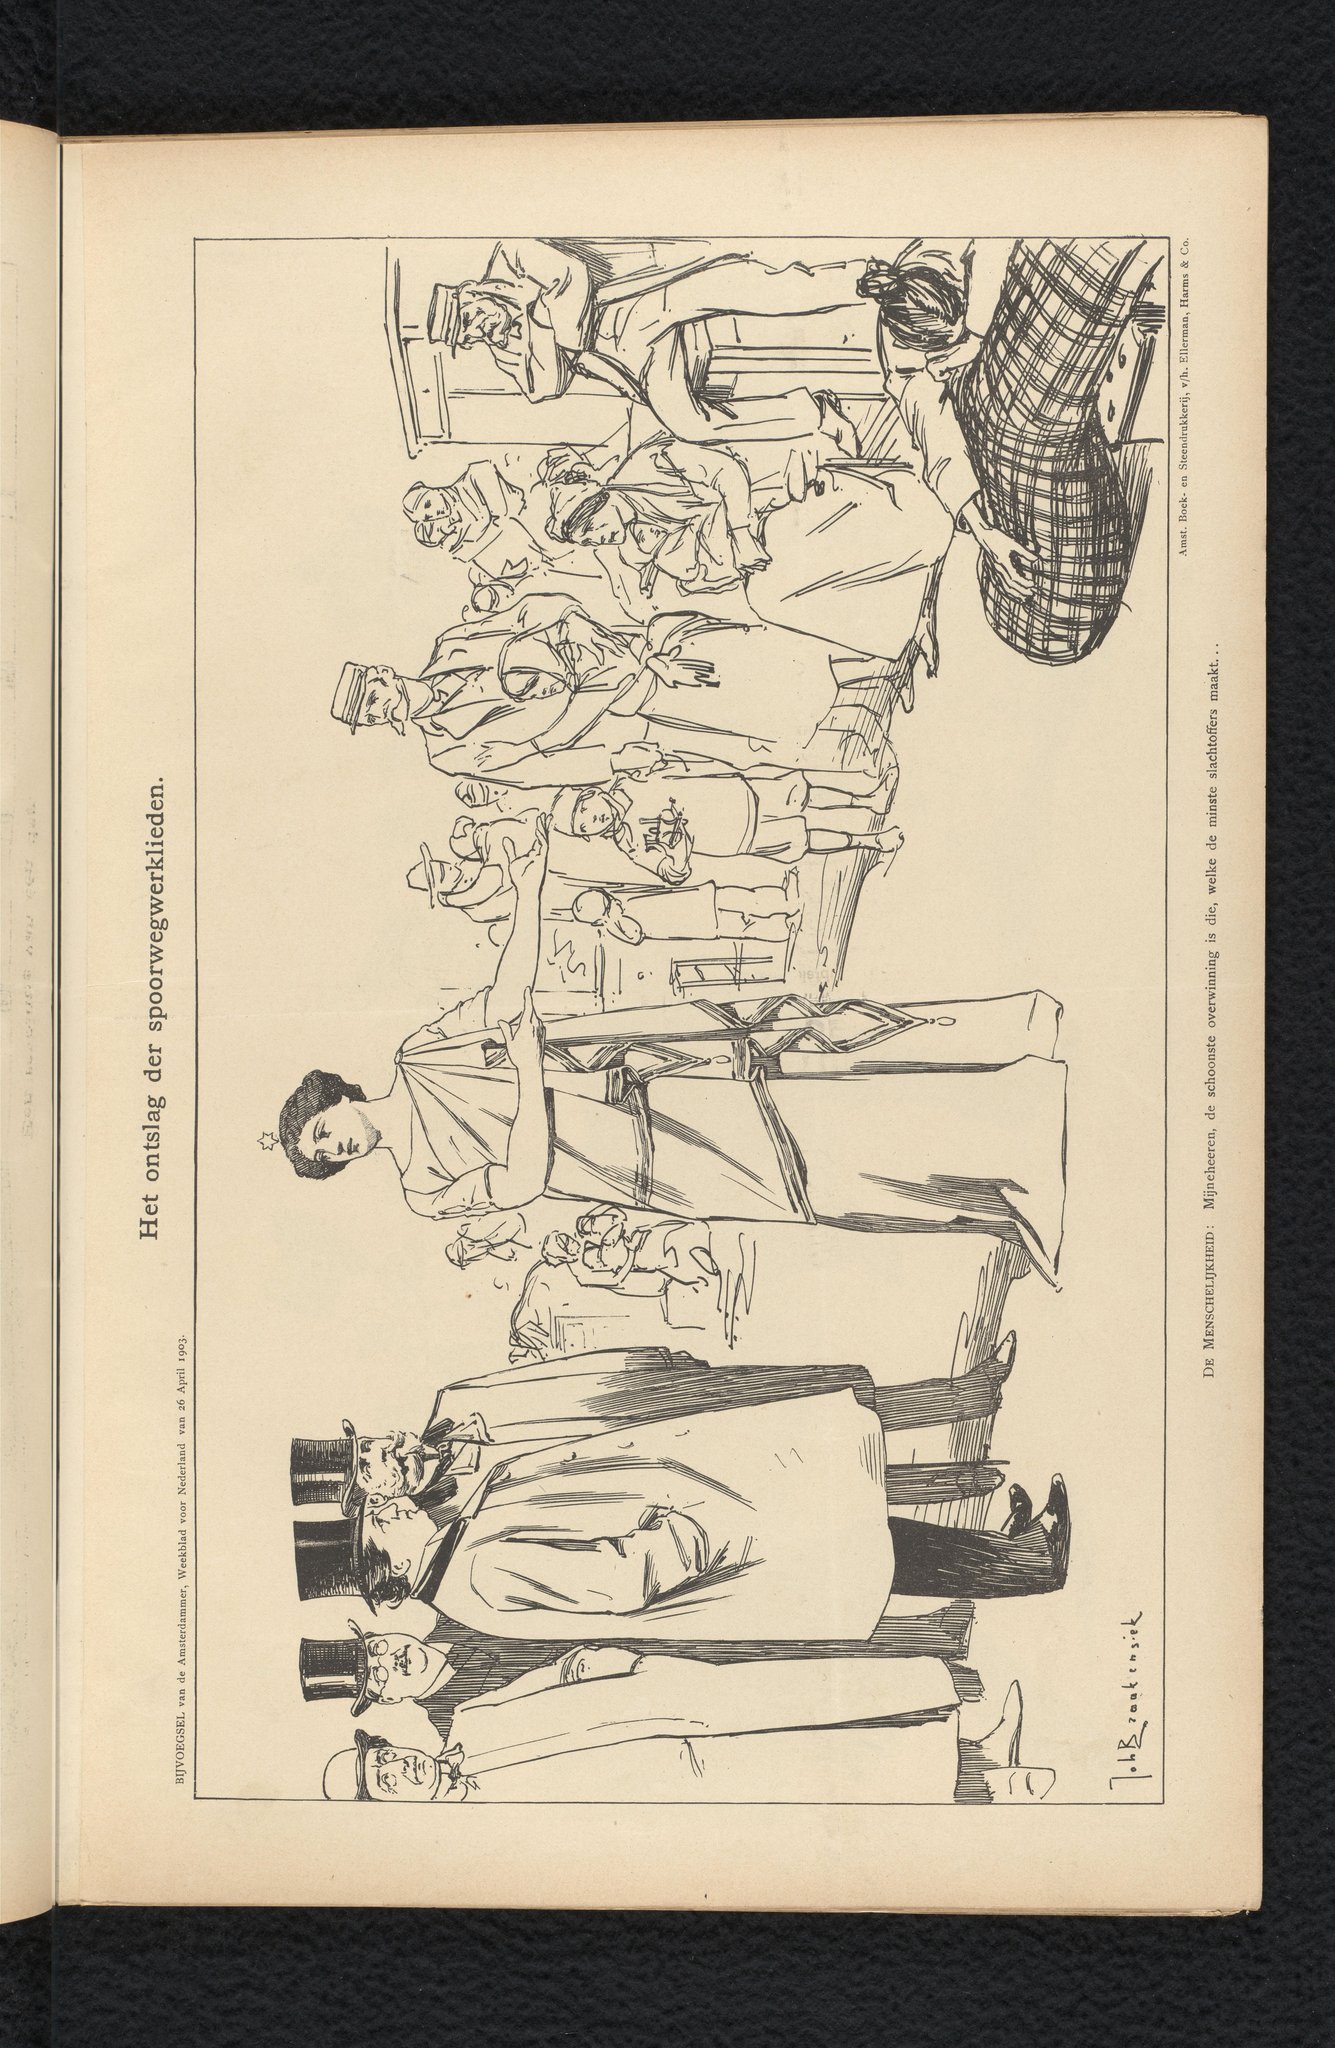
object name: cartoon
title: Het ontslag der spoorwegwerklieden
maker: johan braakensiek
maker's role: draughtsman, print maker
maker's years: 1858-1940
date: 1903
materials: paper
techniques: lithograph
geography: netherlands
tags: the hague, abraham kuyper, the poor, strike (political demonstration), political caricatures and satires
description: De Menselijkheid verzoekt Kuyper en zijn ministers om medelijden met de ontslagen spoorwegarbeiders en hun families.